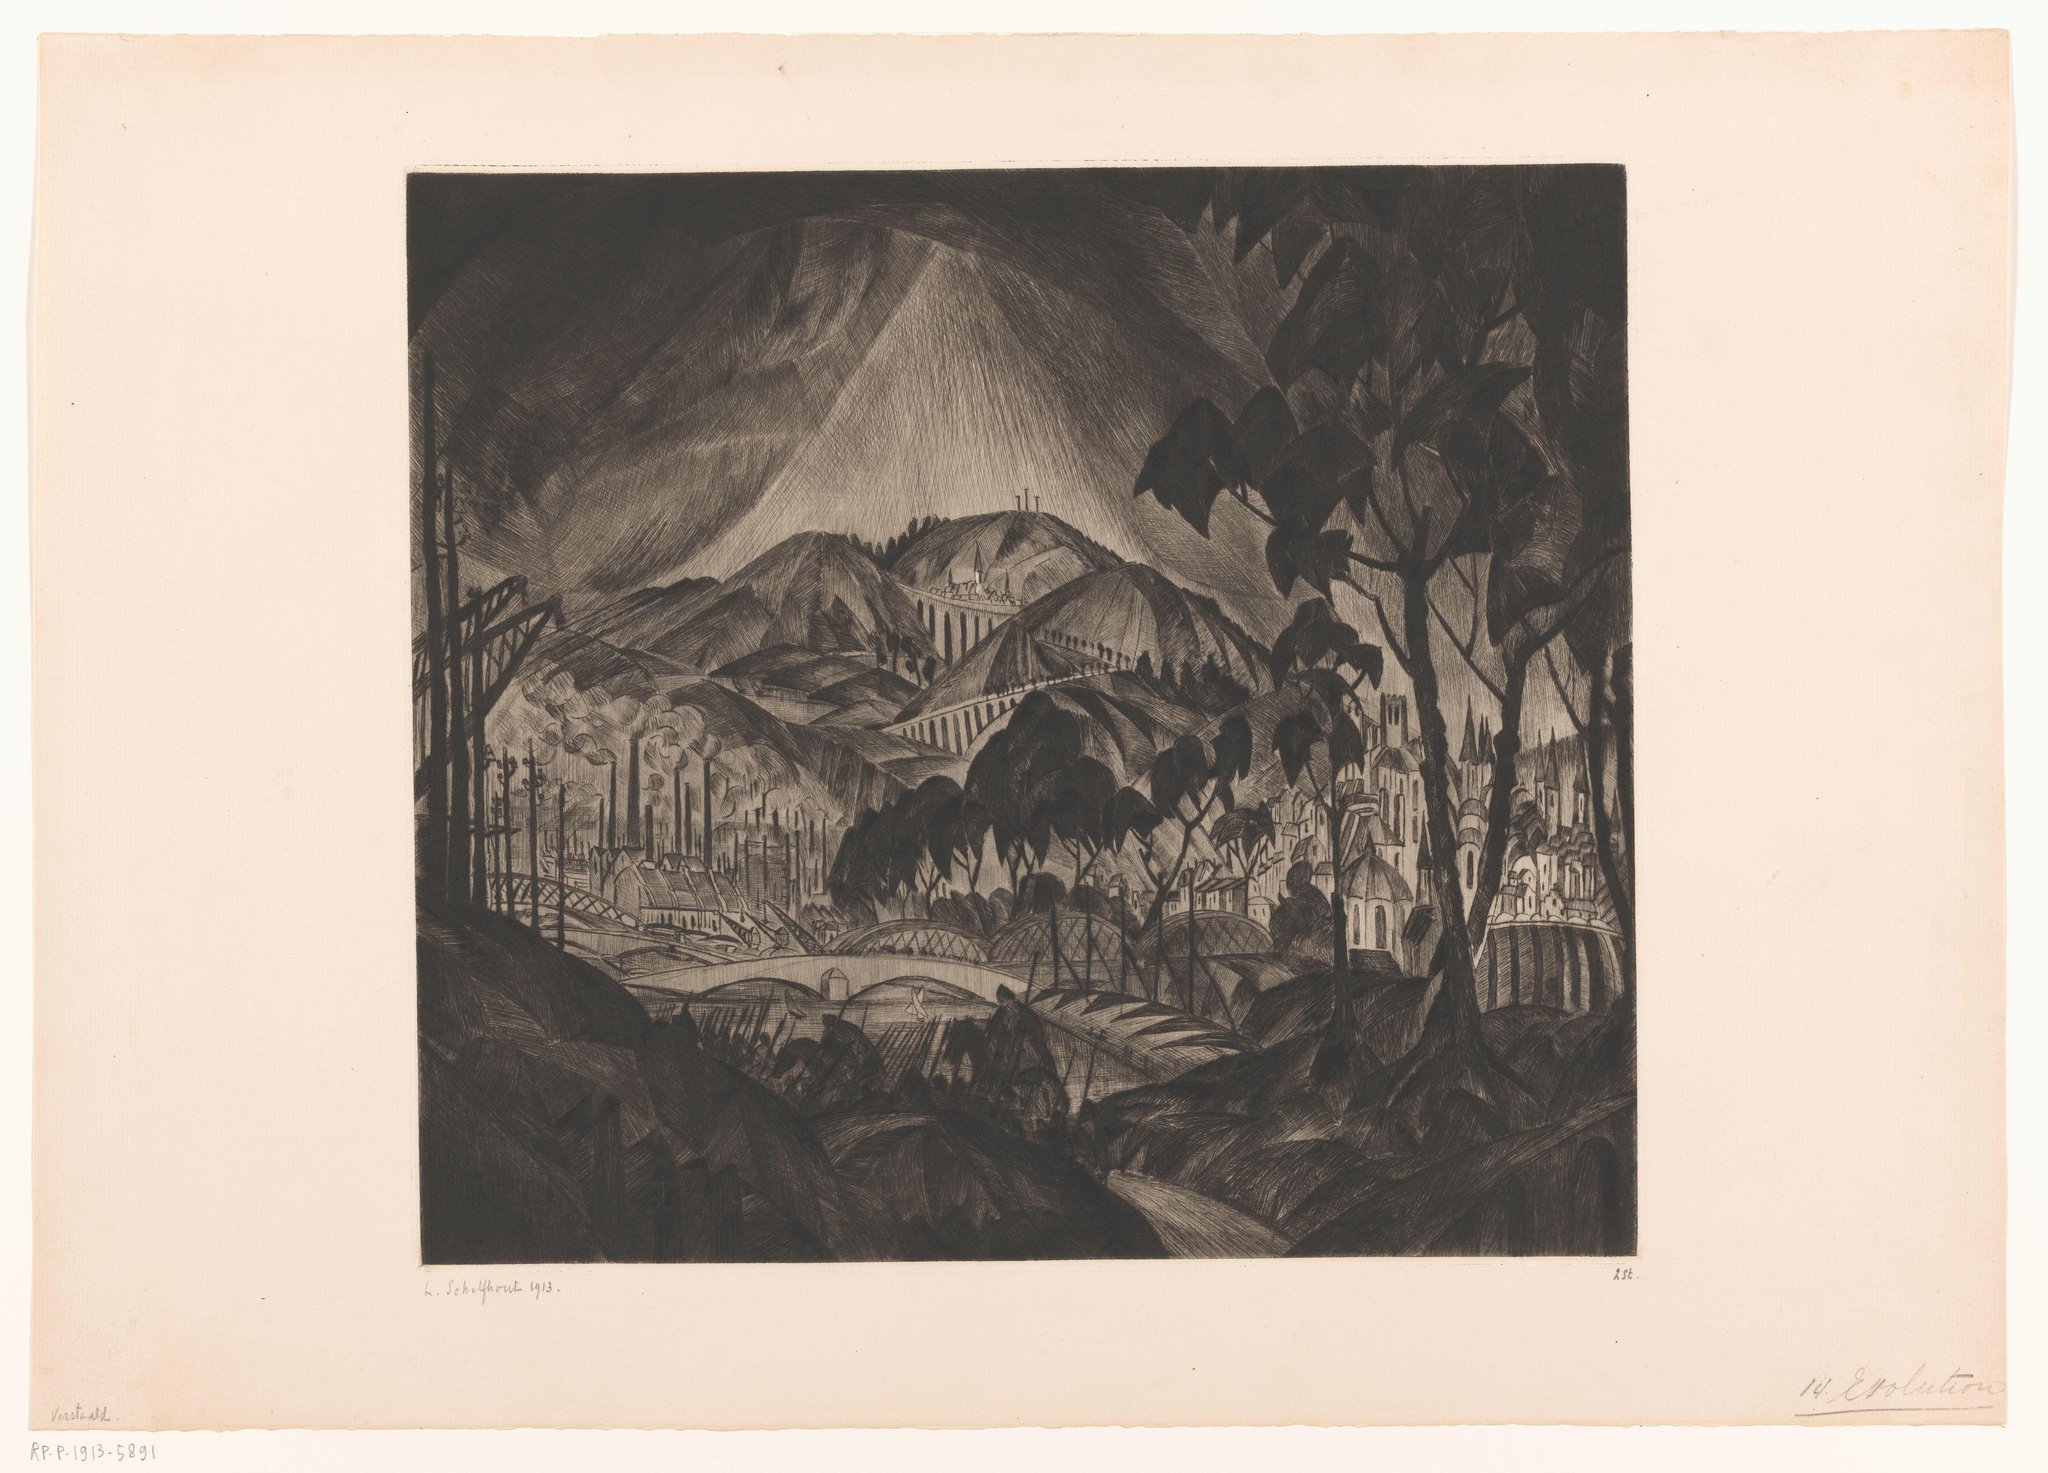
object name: print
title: Evolution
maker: lodewijk schelfhout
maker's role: draughtsman, print maker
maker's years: 1881-1943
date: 1913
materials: paper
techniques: drypoint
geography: netherlands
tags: railway-traffic, city-view in general; 'veduta', factory in landscape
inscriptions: collector's mark: Lugt 2233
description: Op de voorgrond parasolbomen langs een pad. Links op de achtergrond een spoorbrug en fabrieken met rokende schoorstenen bij een meer met zeilschepen. Rechts op de achtergrond een nederzetting.